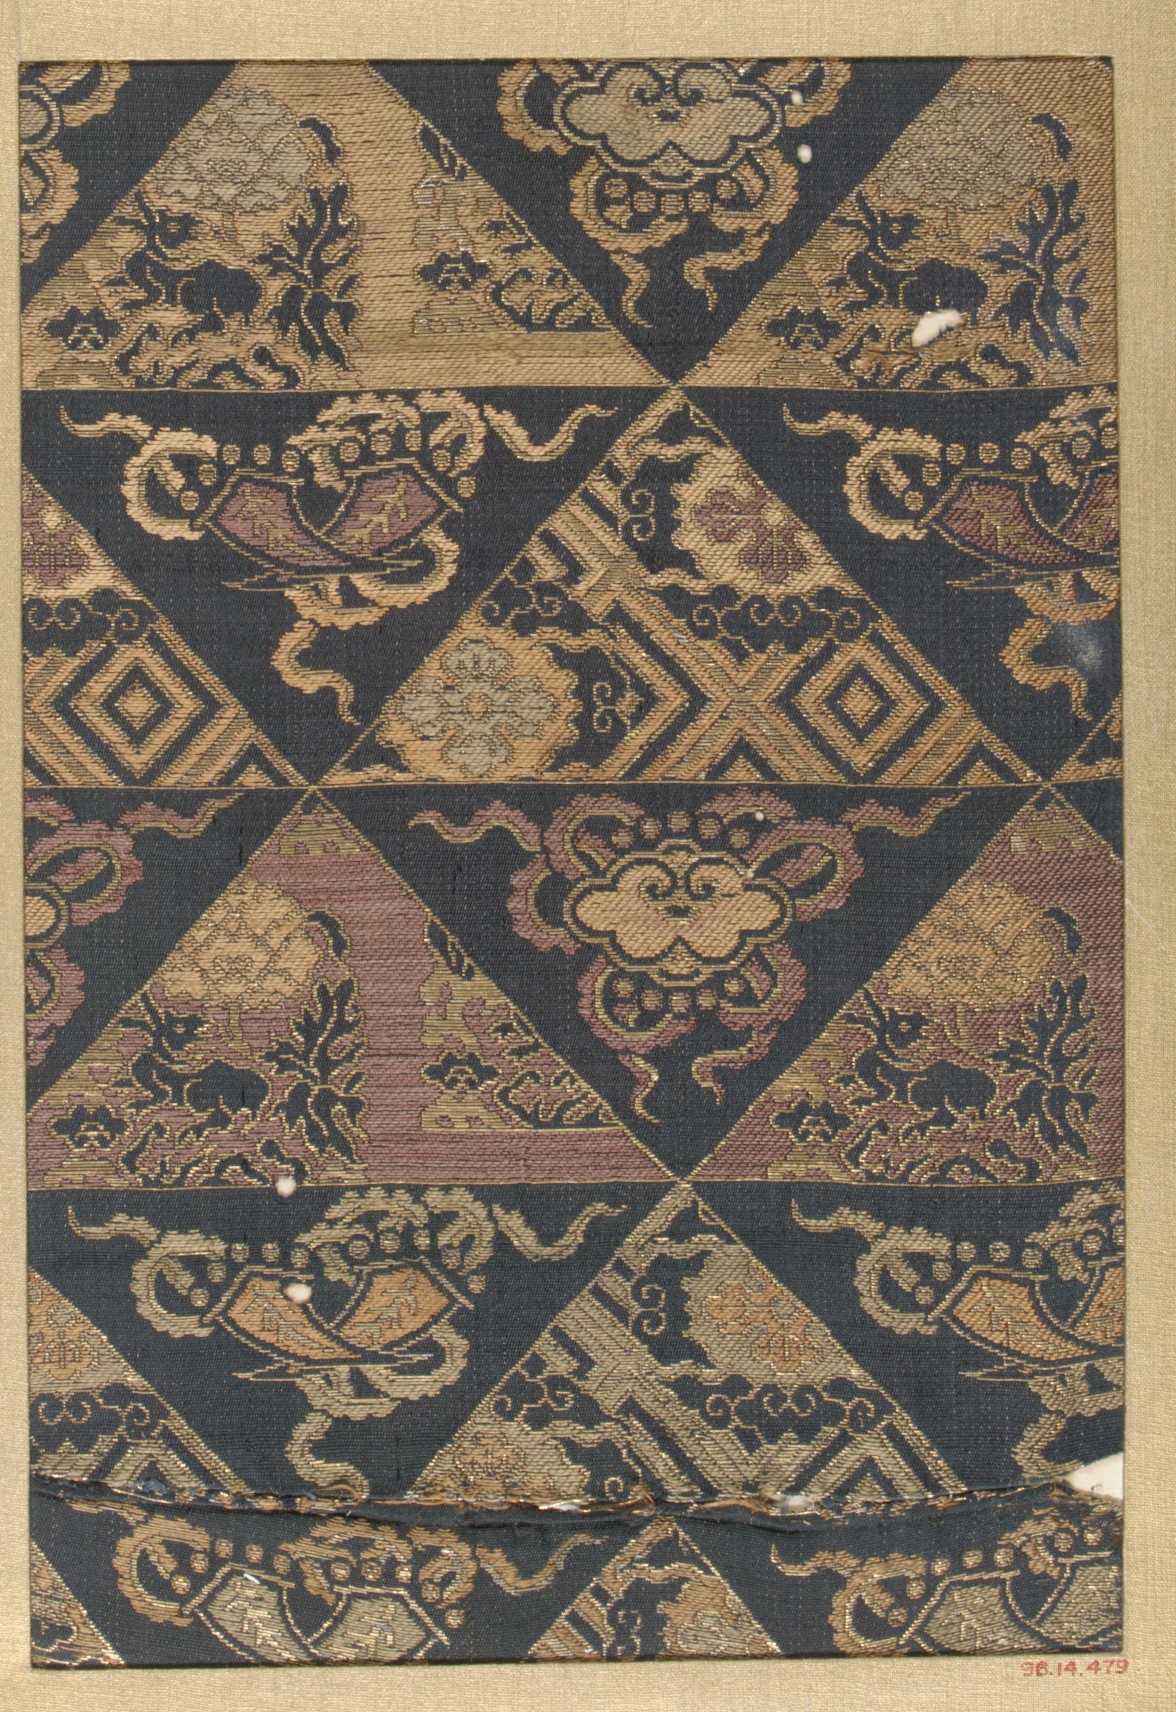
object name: piece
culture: japanese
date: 1701-1900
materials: silk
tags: rabbits